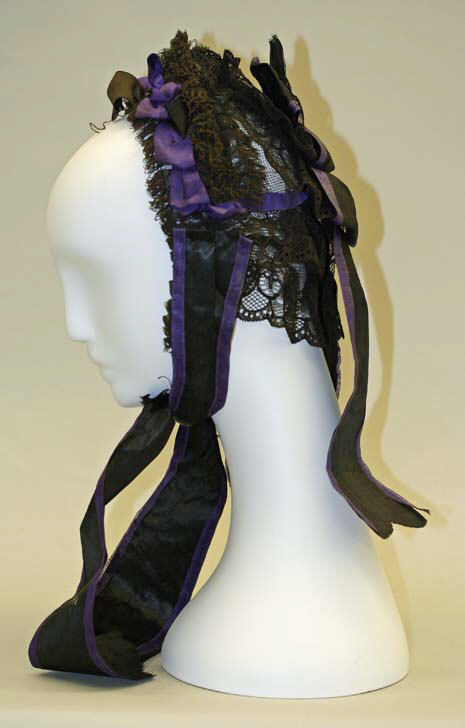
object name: cap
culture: american or european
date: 1864-1865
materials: silk